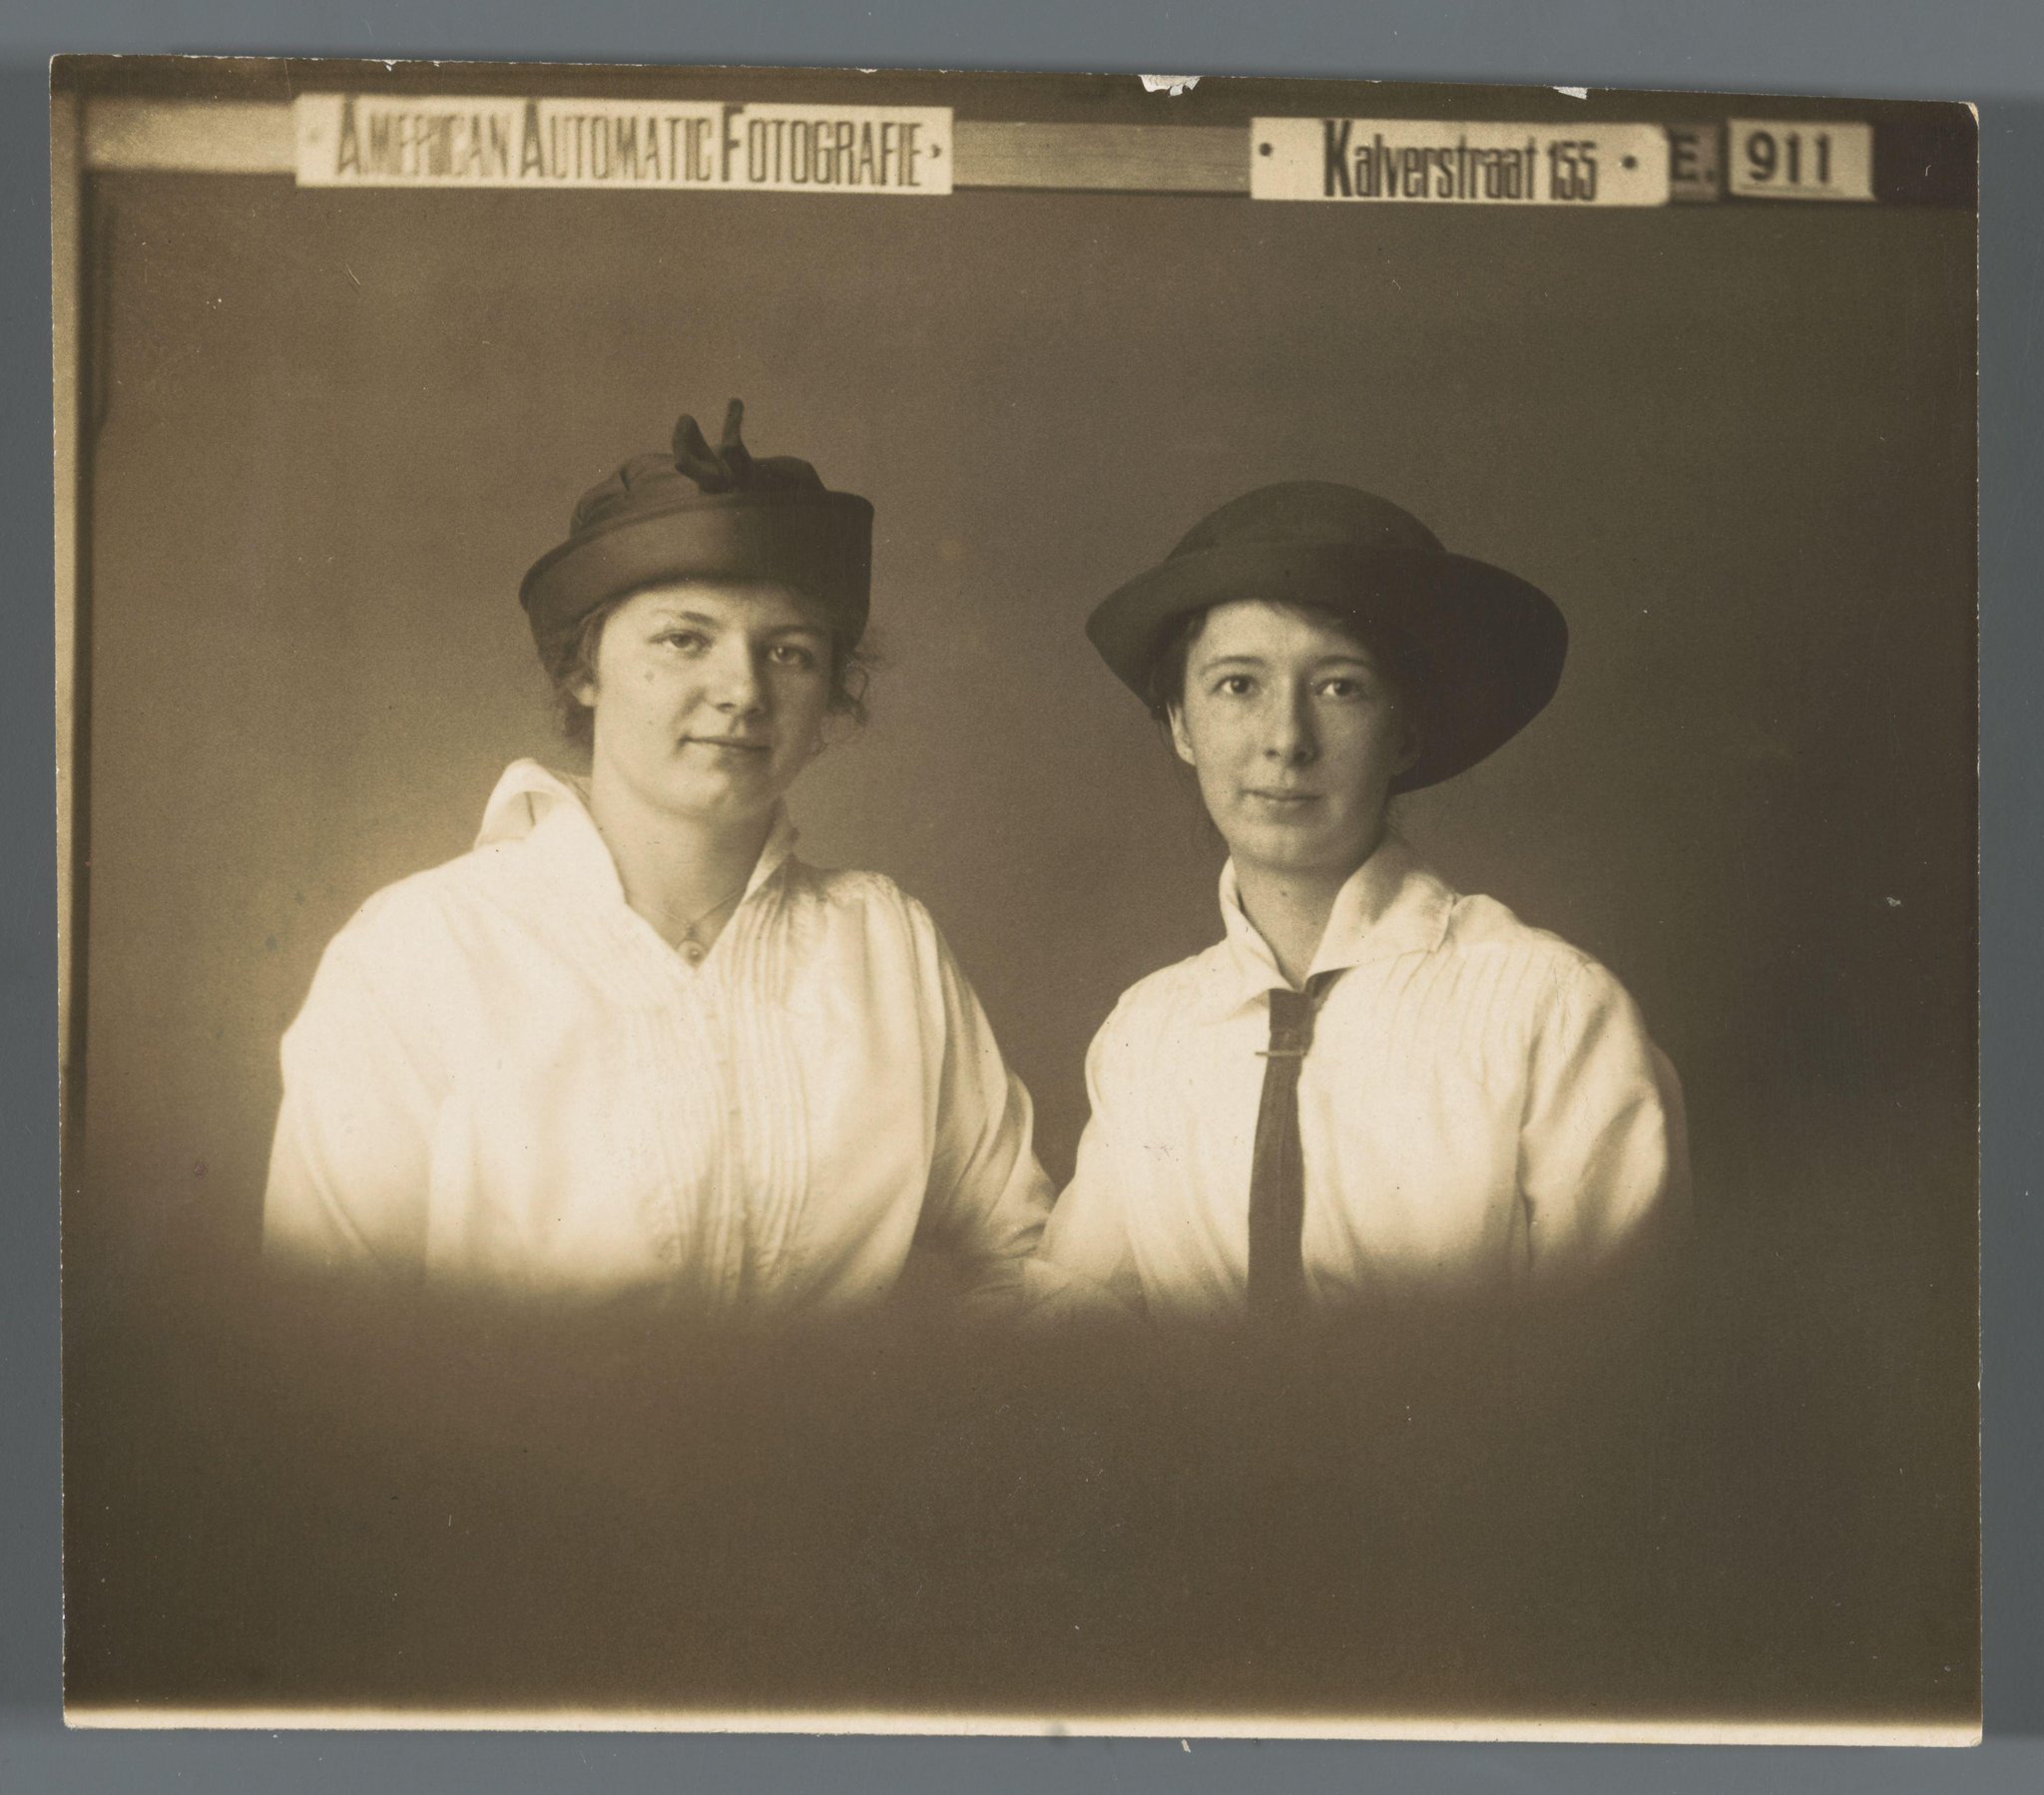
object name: snapshot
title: Rapid photographs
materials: paper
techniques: gelatin silver print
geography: amsterdam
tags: johanna hermina marmelstein, historical persons - bb - woman, amsterdam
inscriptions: inscription: ‘American Automatic Fotografie/ Kalverstraat 155/ 911’, annotation: ‘Amsterdam 27-4-'16/ Katy Engel + H Marmelstein’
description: Between 1912 and 1930, anyone could have their portrait taken at the many so-called rapid photography studios in the shopping streets of mainly (medium) large-size European cities. As if on an assembly line, the youngest clerk shot the photographs with a special camera and in artificial light and developed them. Later in the day, the customer collected a sheet with 12 portrait photos for 25 cents. This form of photographic mass production gave rise to a fascinating tableau of boys, girls, men and women not previously seen in photographs; candid and informal. There were at least 150 quick-photo studios, from Alkmaar to Zutphen. Many called themselves ‘American,’ mistakenly as it turns out because hardly any examples from that country have been found.